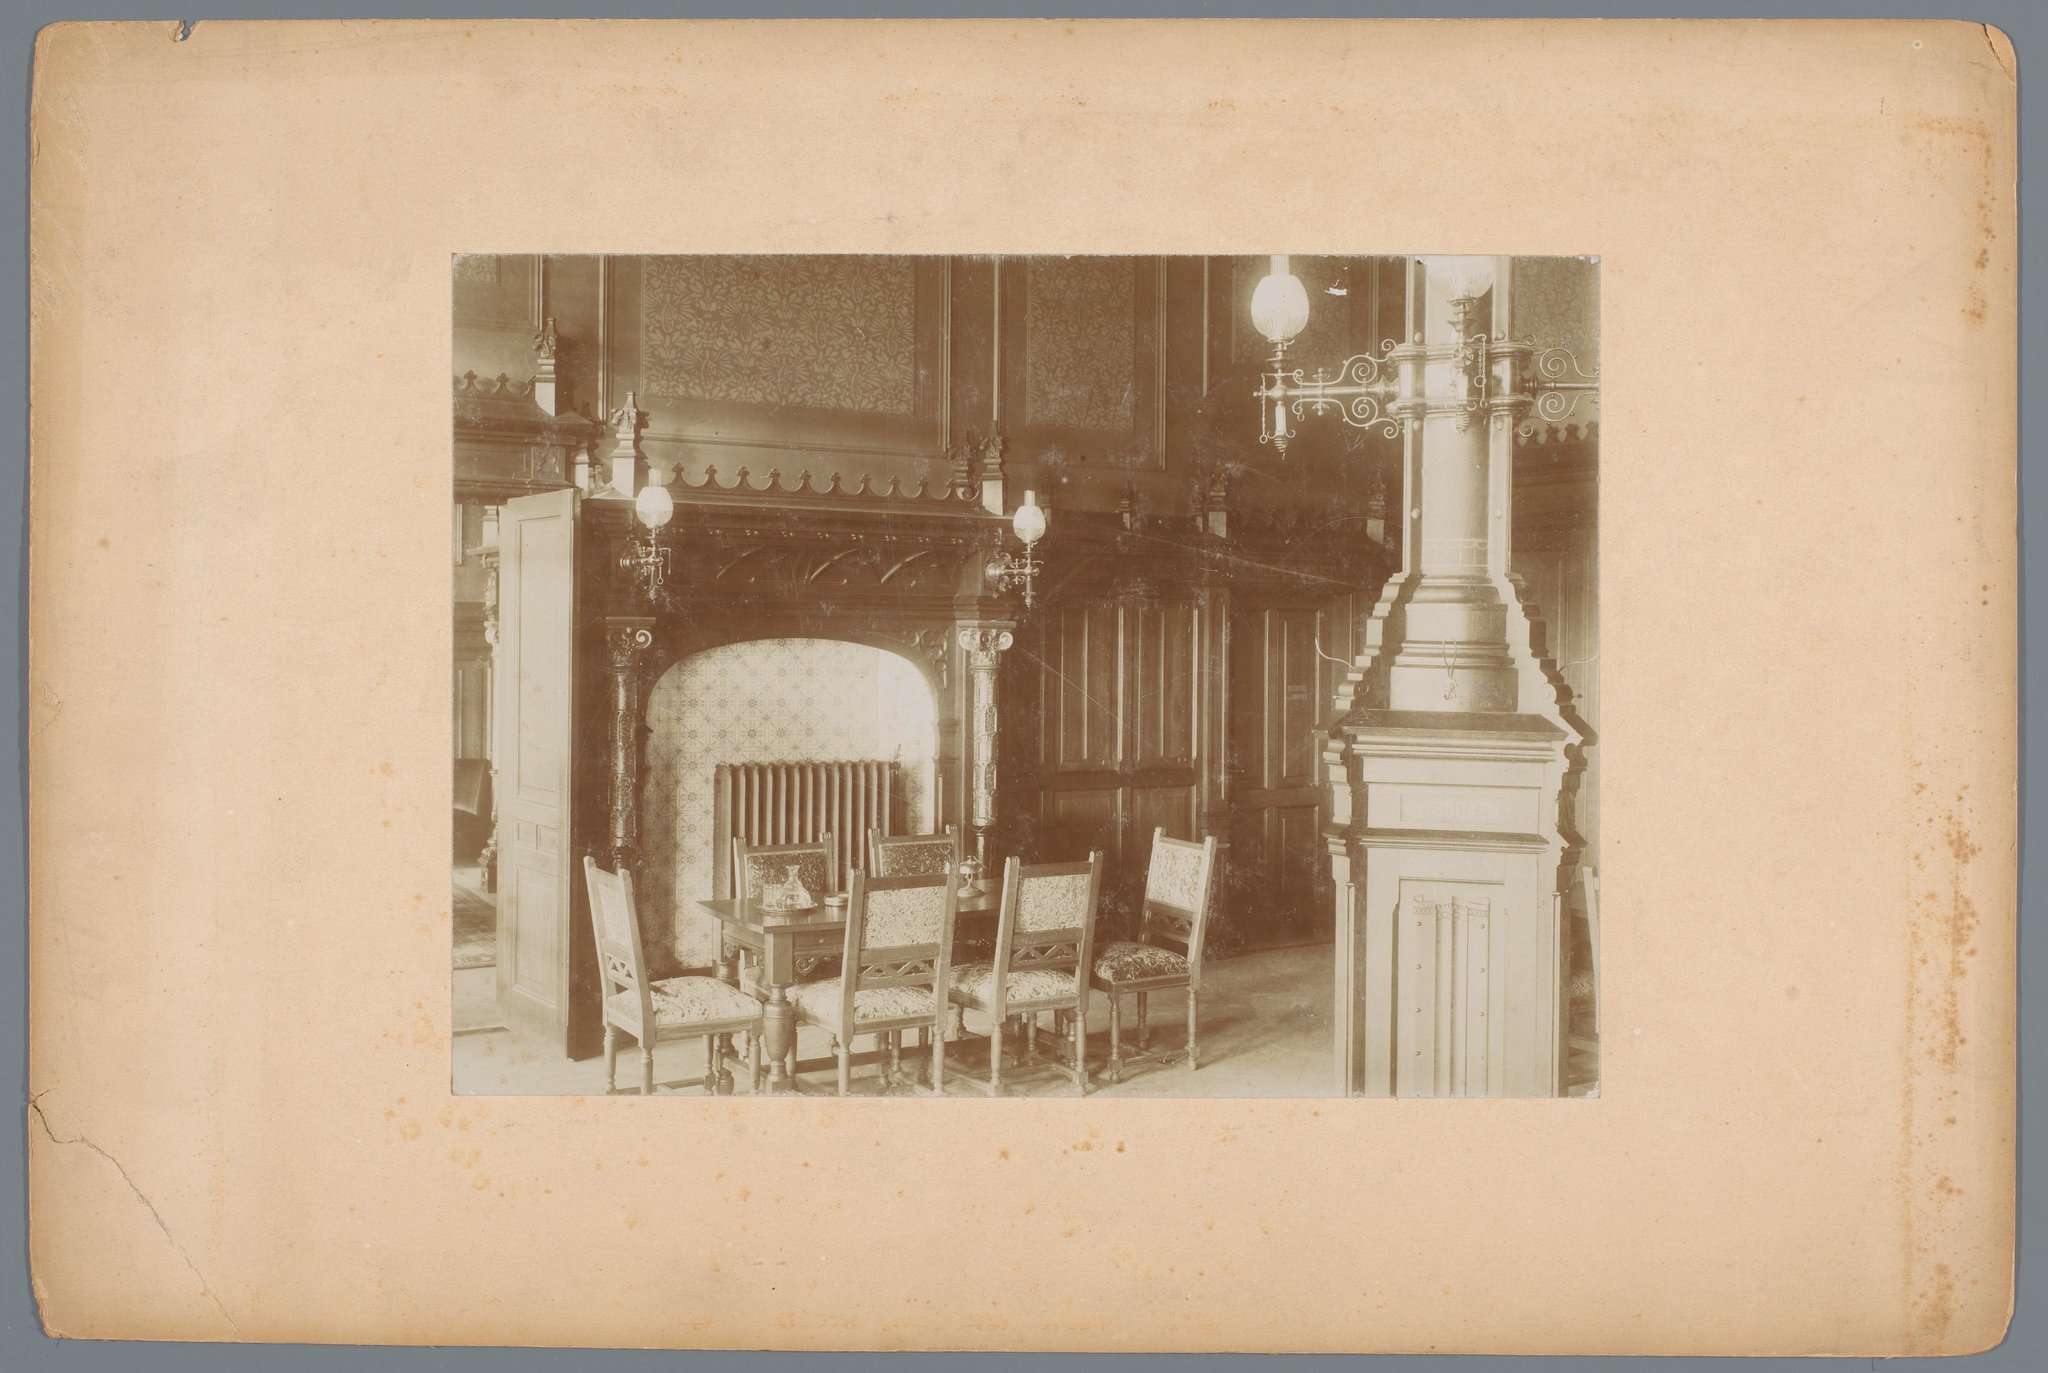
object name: photograph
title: Interieur van (vermoedelijk) een restaurant te Amsterdam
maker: e. van elfrinkhoff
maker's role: fotograaf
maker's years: 1860-1921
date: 1875-1900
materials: cardboard, photographic support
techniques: collodion silver print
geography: amsterdam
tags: table, interior ~ representation of a building, restaurant, amsterdam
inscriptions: name: ‘E. van ELFRINKHOFF AMSTERDAM Sport & Landsch. Fotograaf.’